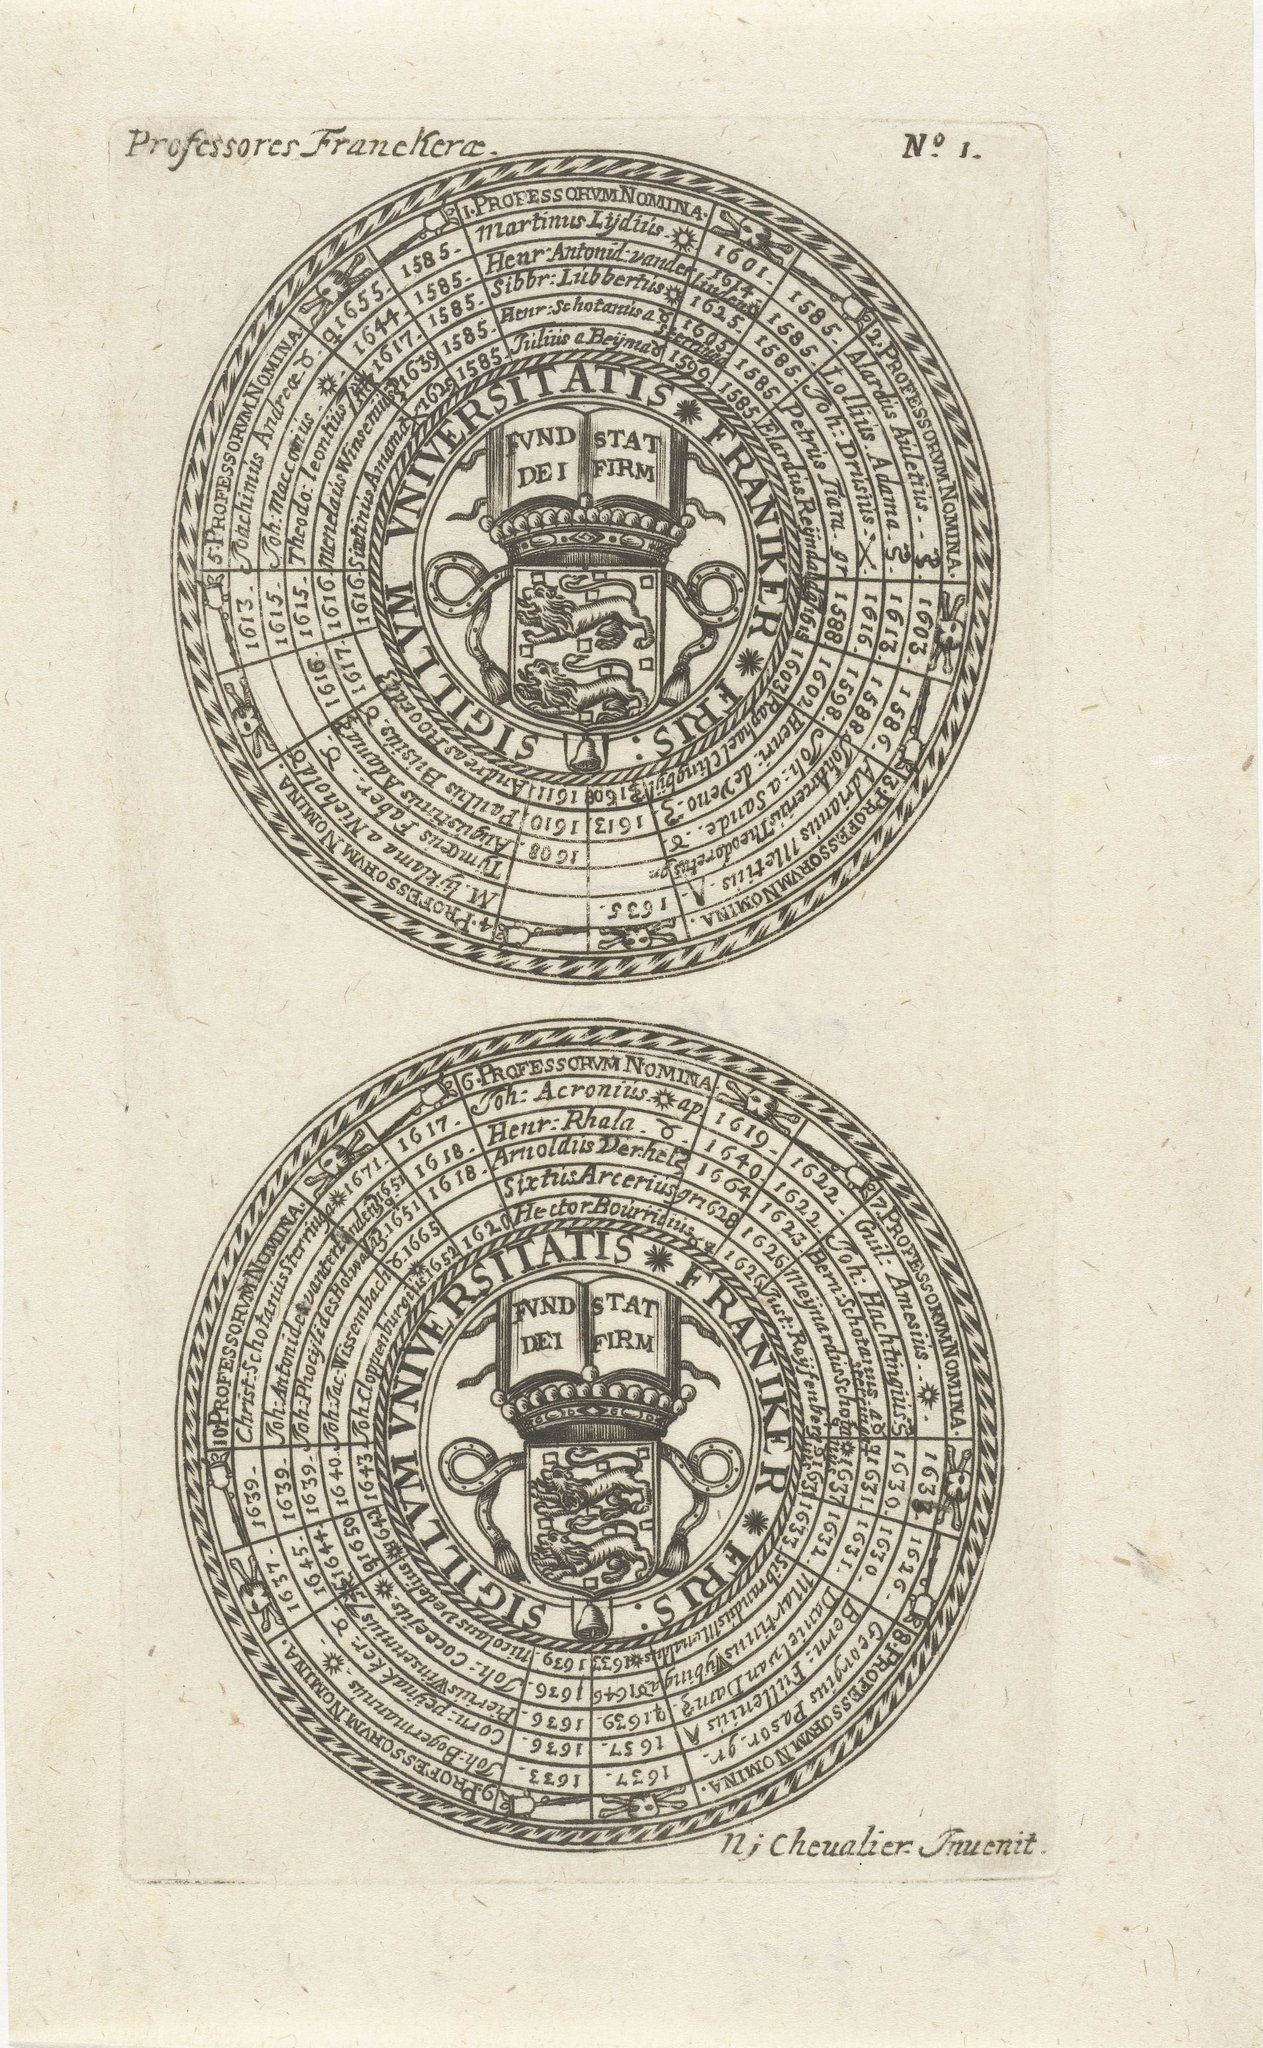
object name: print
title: Zegels van de Universiteit van Franeker, met namen van de hoogleraren en het wapen van de universiteit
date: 1685-1720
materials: paper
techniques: engraving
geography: netherlands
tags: insignia, seal ~ university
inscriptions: collector's mark: Lugt 2228